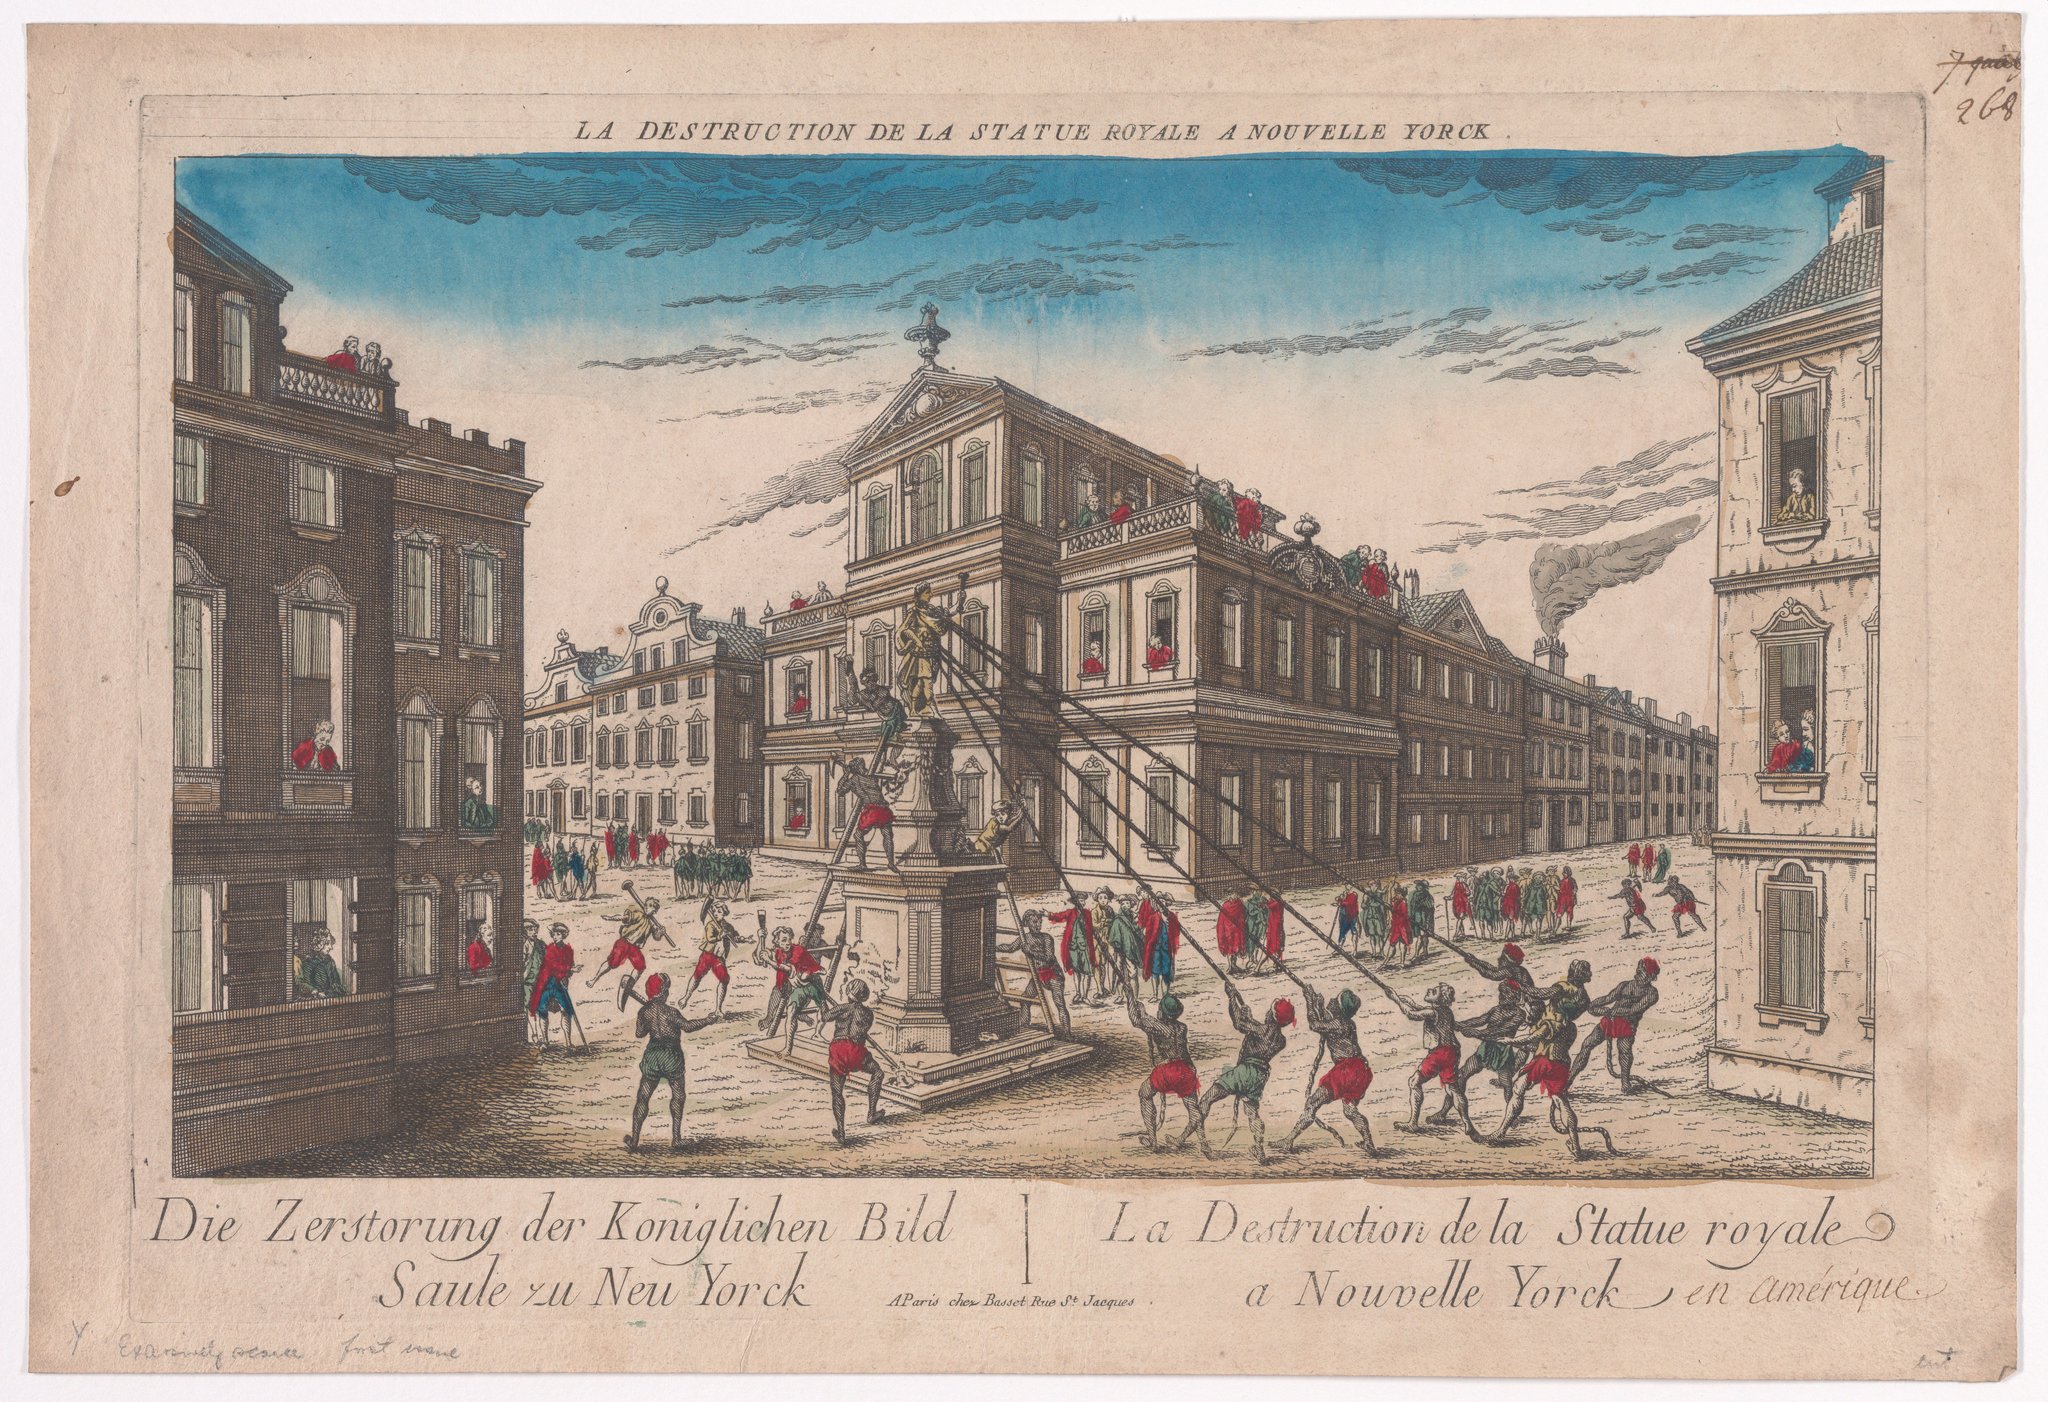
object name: print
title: The Destruction of the Royal Statue at New York on July 9, 1776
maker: anonymous, french, 18th century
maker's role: engraver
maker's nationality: french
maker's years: 1700-1800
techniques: engraving, etching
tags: new york city